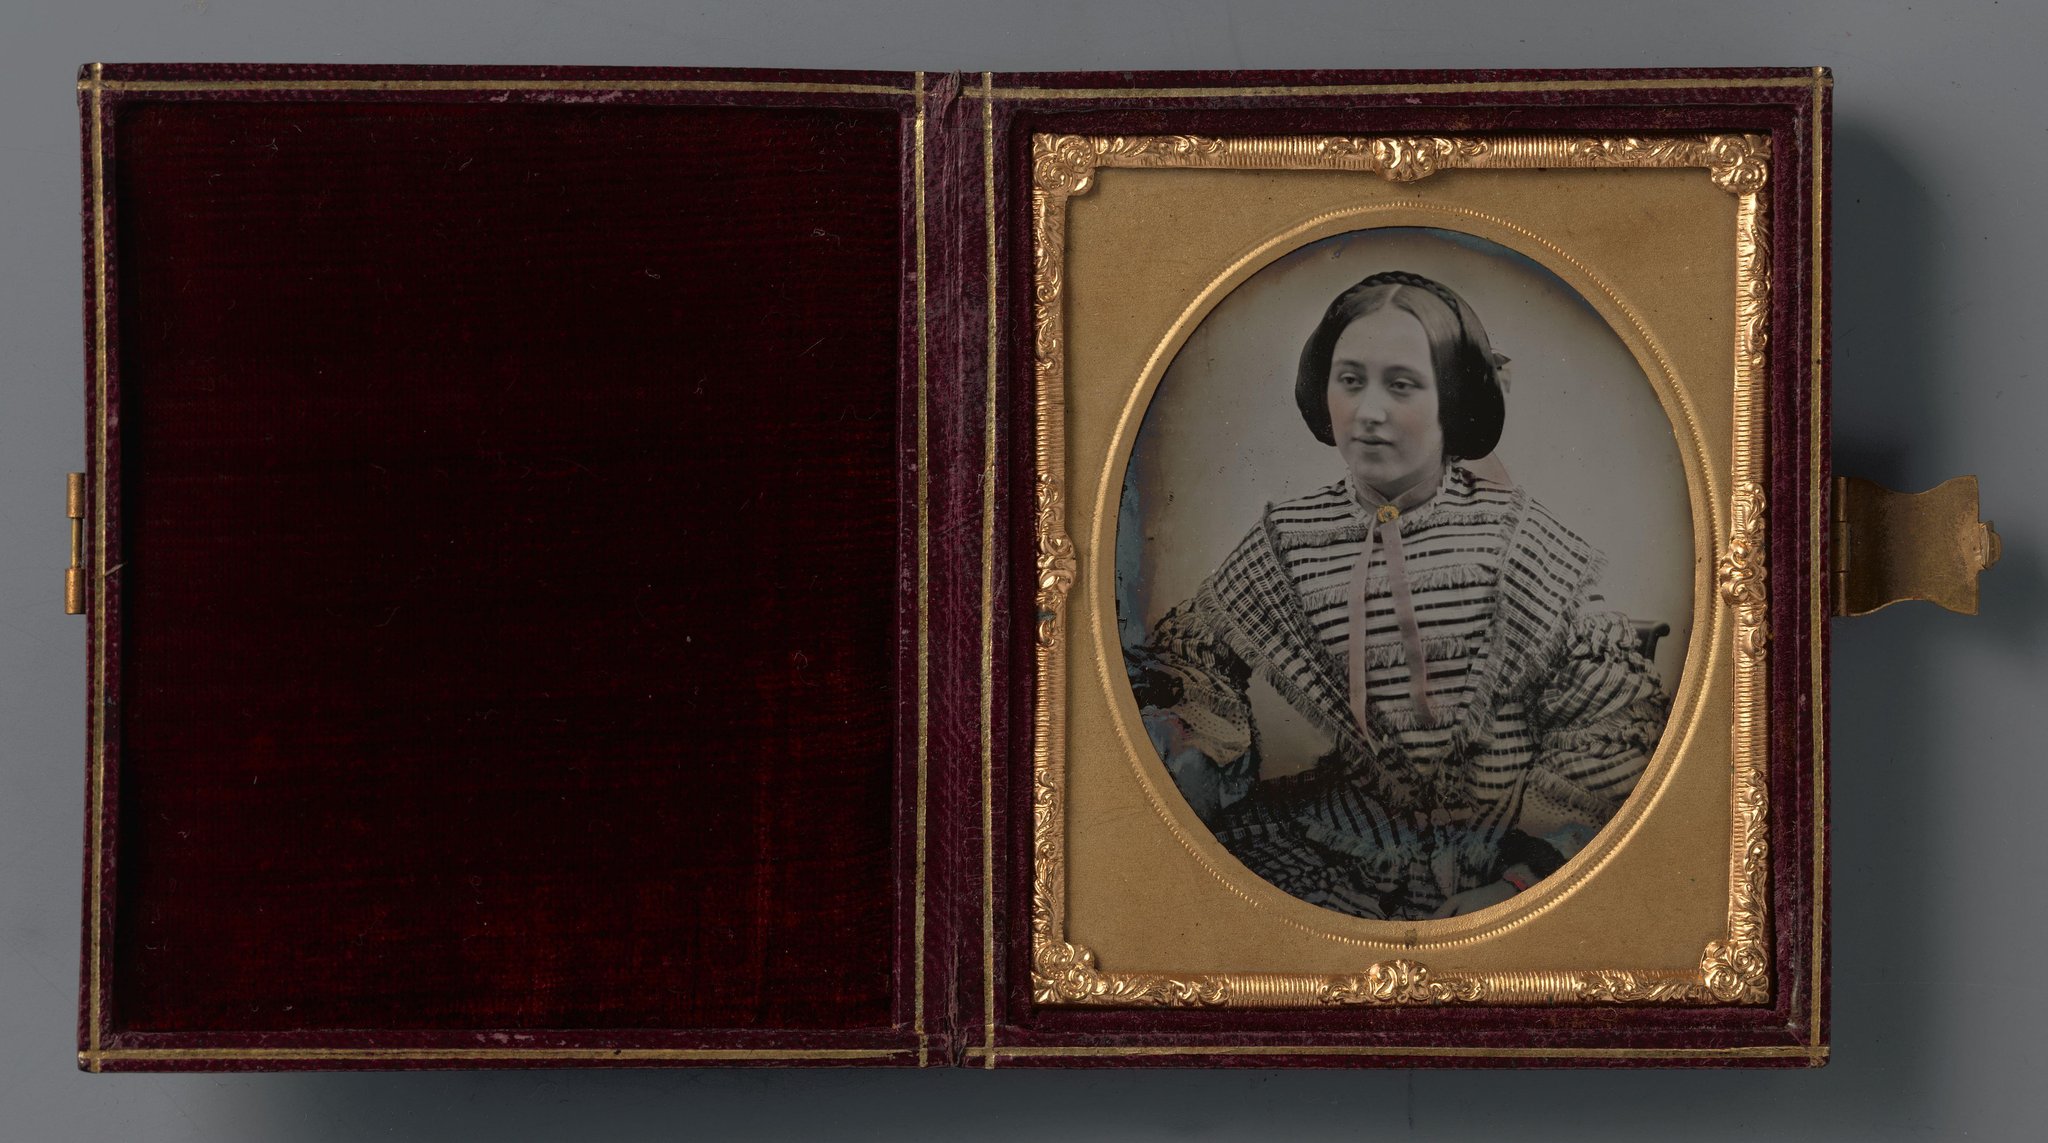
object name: photograph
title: Portret van een onbekende jonge vrouw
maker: Anonymous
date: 1855-1870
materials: glass, metal, velvet, wood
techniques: ambrotype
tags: adolescent, young woman, maiden, historical persons - bb - woman